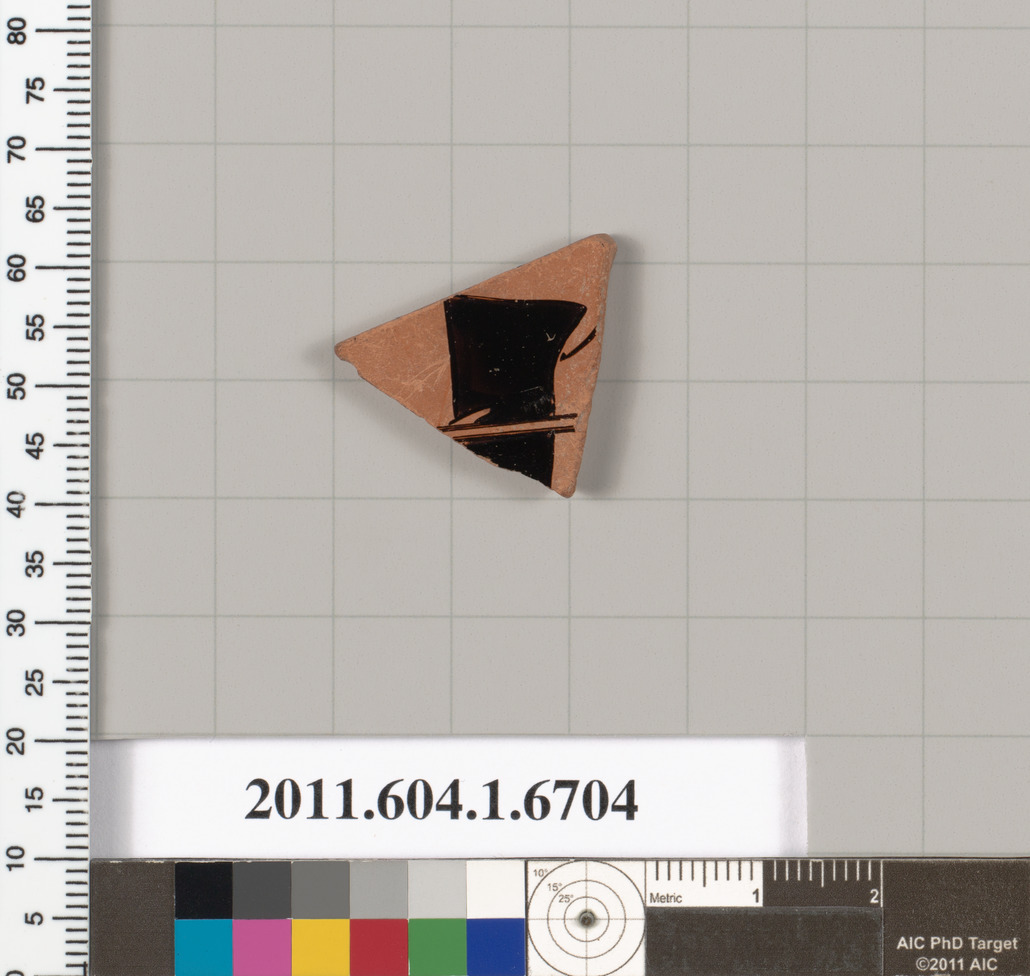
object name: kylix fragment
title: Terracotta fragment of a kylix (drinking cup)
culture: greek, attic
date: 490-470 BCE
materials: terracotta